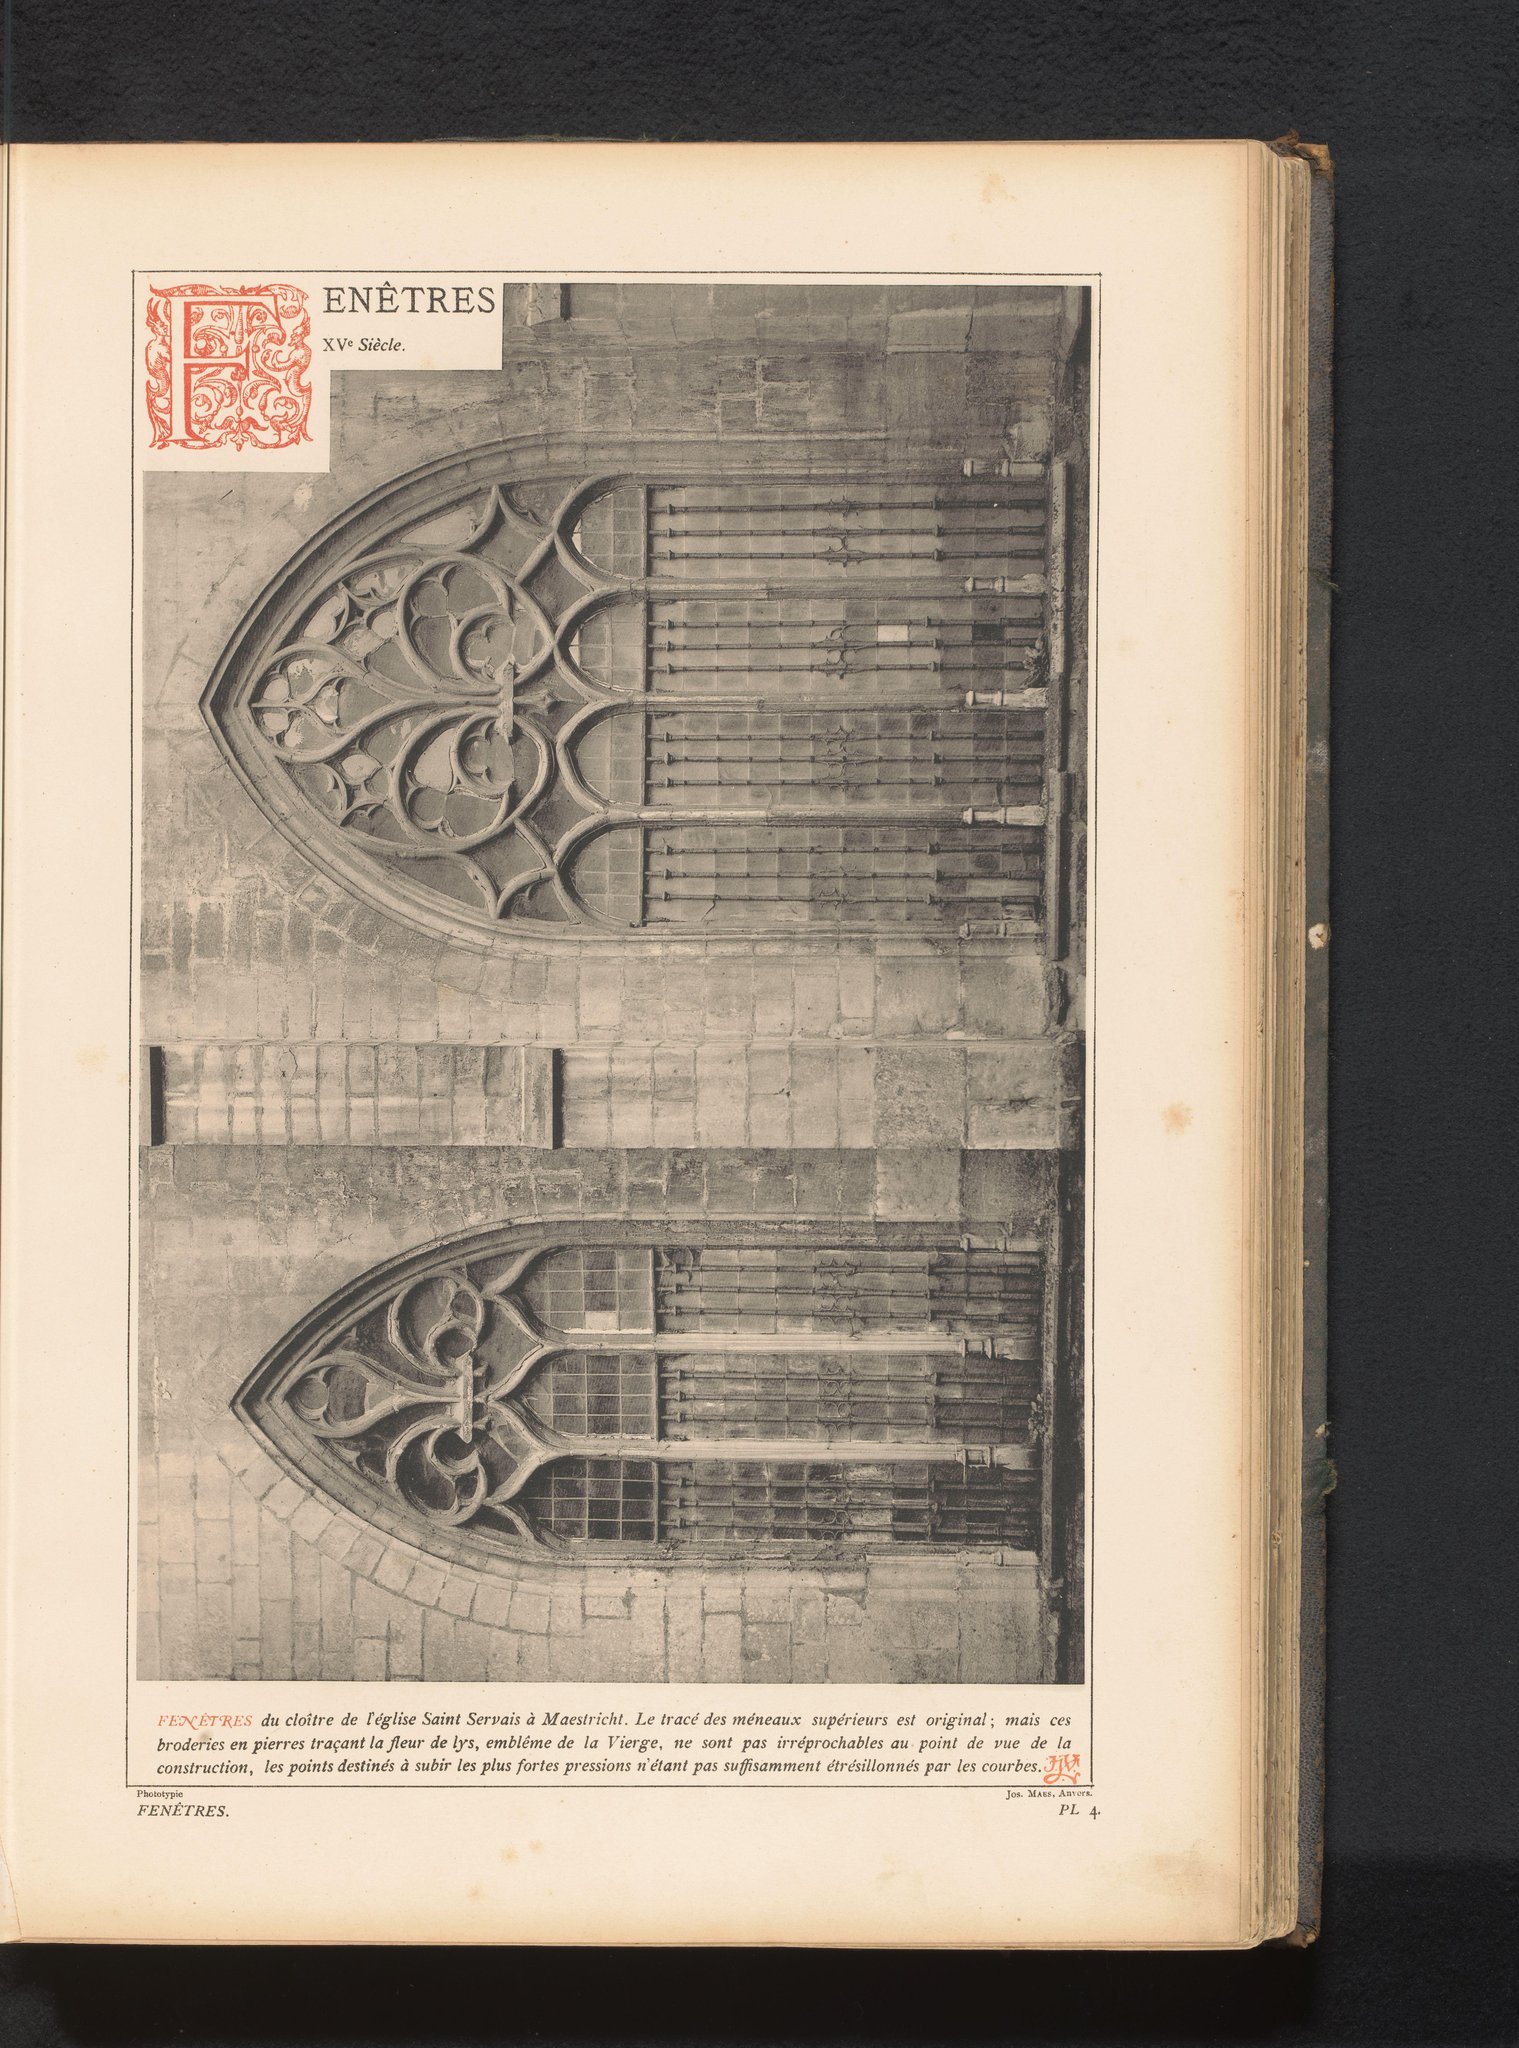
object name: page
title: Fenêtres, XVe siècle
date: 1882-1887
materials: paper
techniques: photograph, photolithography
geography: maastricht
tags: window, maastricht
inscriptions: monogram: ‘JJvY’, inscription: ‘FENÊTRES. - PL. 4.’, inscription: ‘FENÊTRES du cloître (...)’